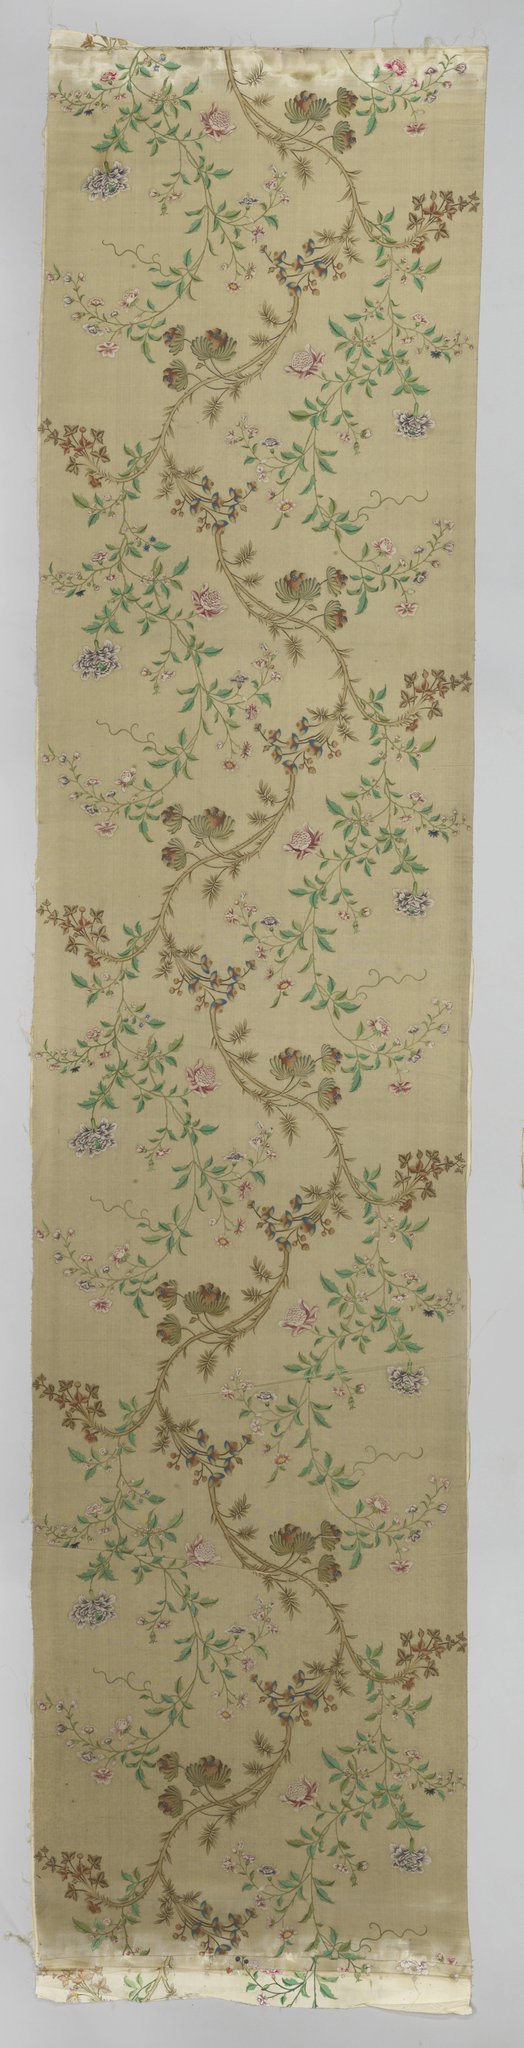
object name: upholstery fabric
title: Bespanningsstof met decor van takken, bladeren, bloemen en vruchten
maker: Anonymous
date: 1750-1790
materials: paint, silk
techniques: printing, weave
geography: china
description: Een baan veelkleurig beschilderde creme bespanningsstof van zijde. Zie beschrijving A.